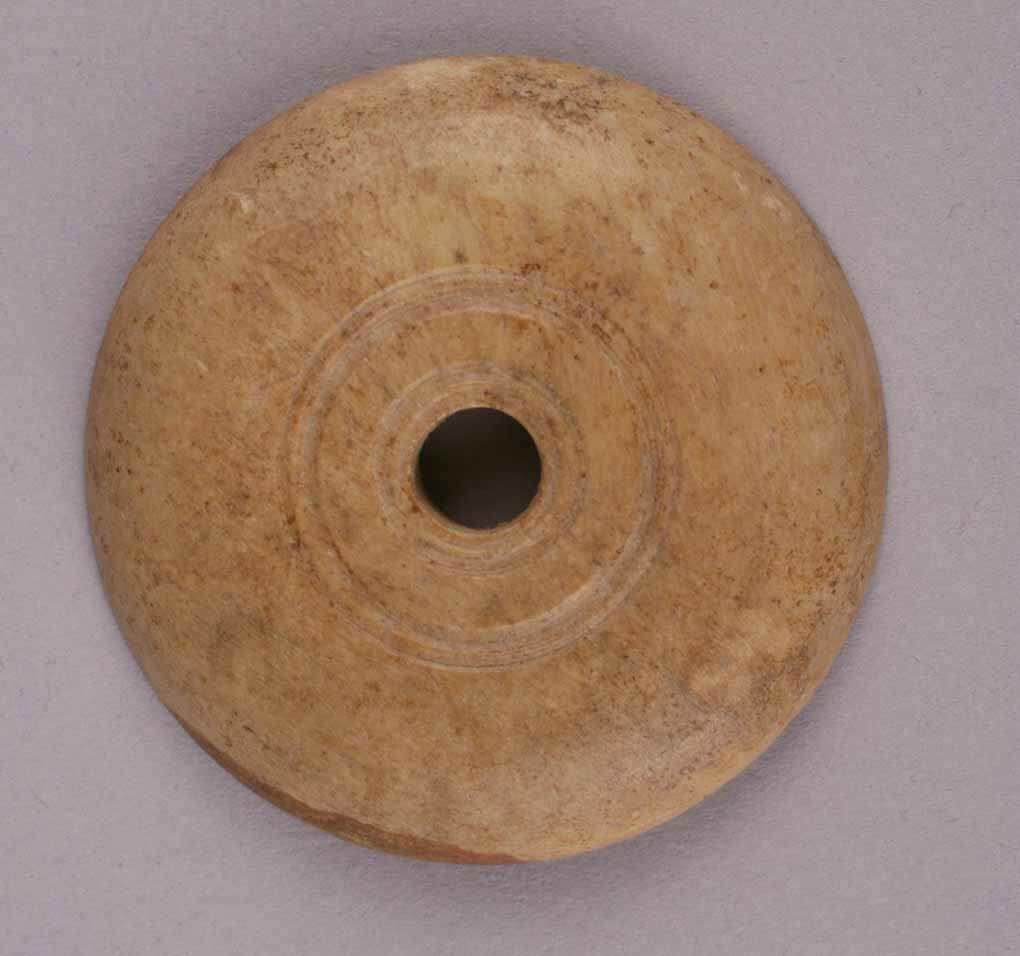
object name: spindle whorl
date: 801-1000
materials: bone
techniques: incising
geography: iran